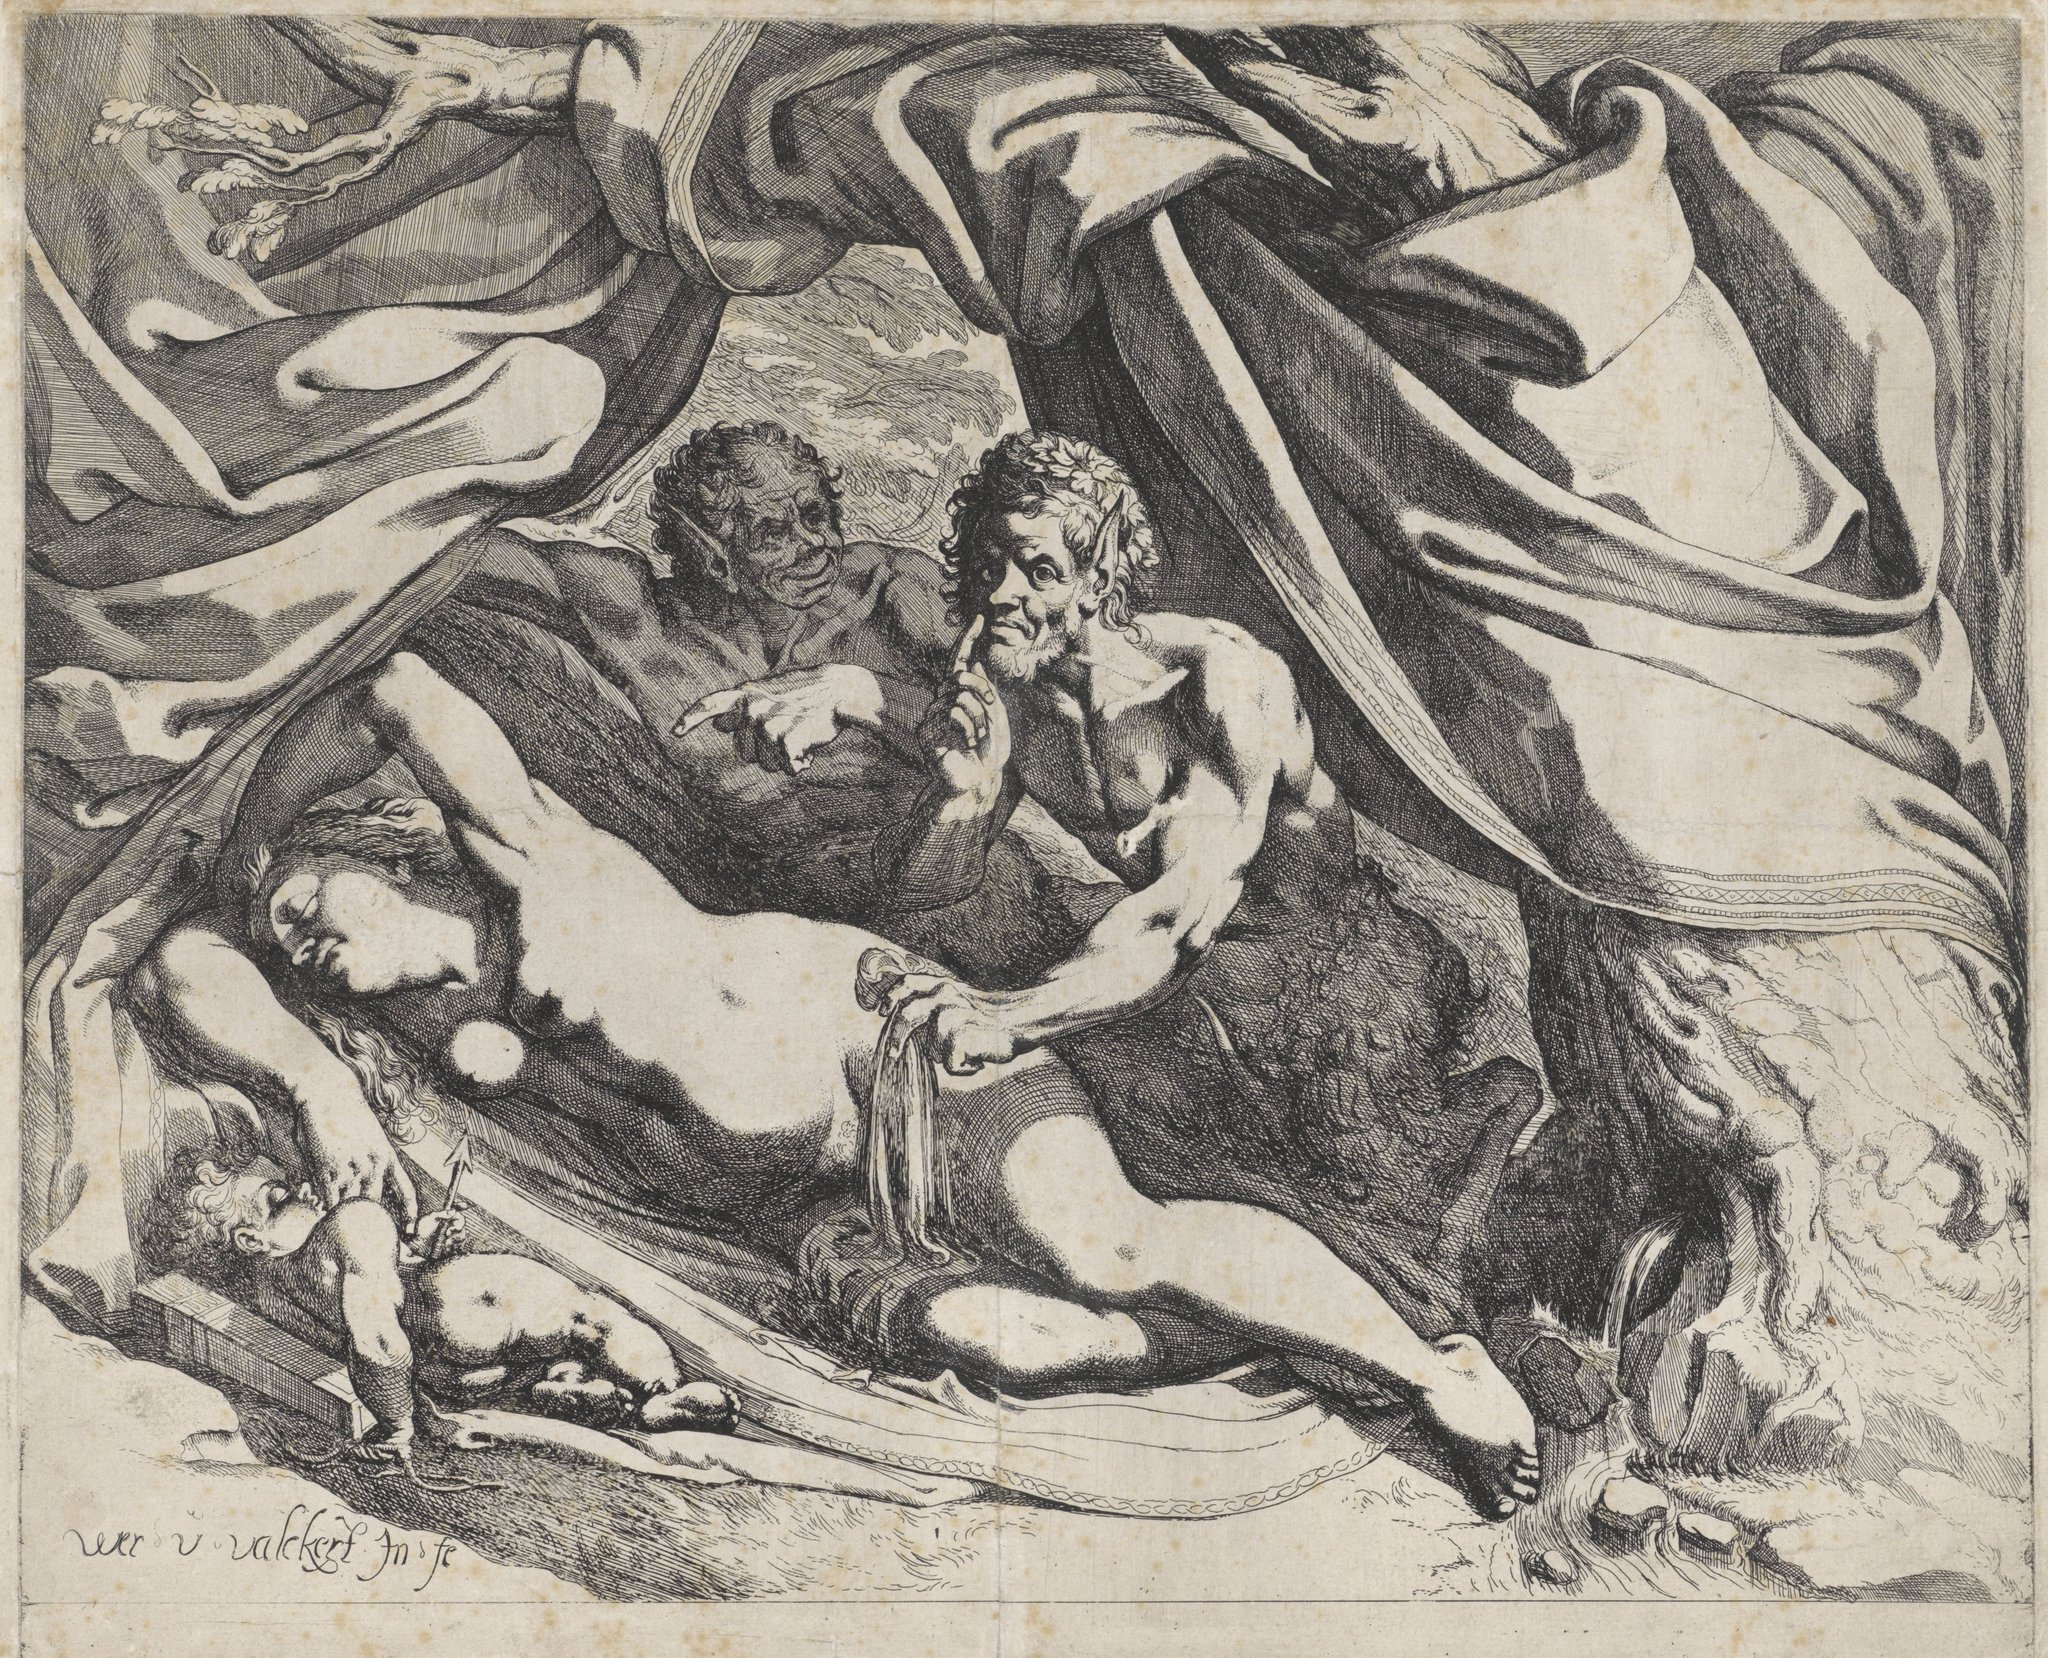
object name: print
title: Slapende Venus door saters bespied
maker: werner van den valckert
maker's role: draughtsman, painter, print maker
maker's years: 1580-1627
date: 1610-1612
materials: paper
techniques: etching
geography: the hague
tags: satyr(s) spying upon, venus and cupid (cupid not being mere attribute)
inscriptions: collector's mark: Lugt 240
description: Slapende Venus, met naast haar Amor, door saters bespied.